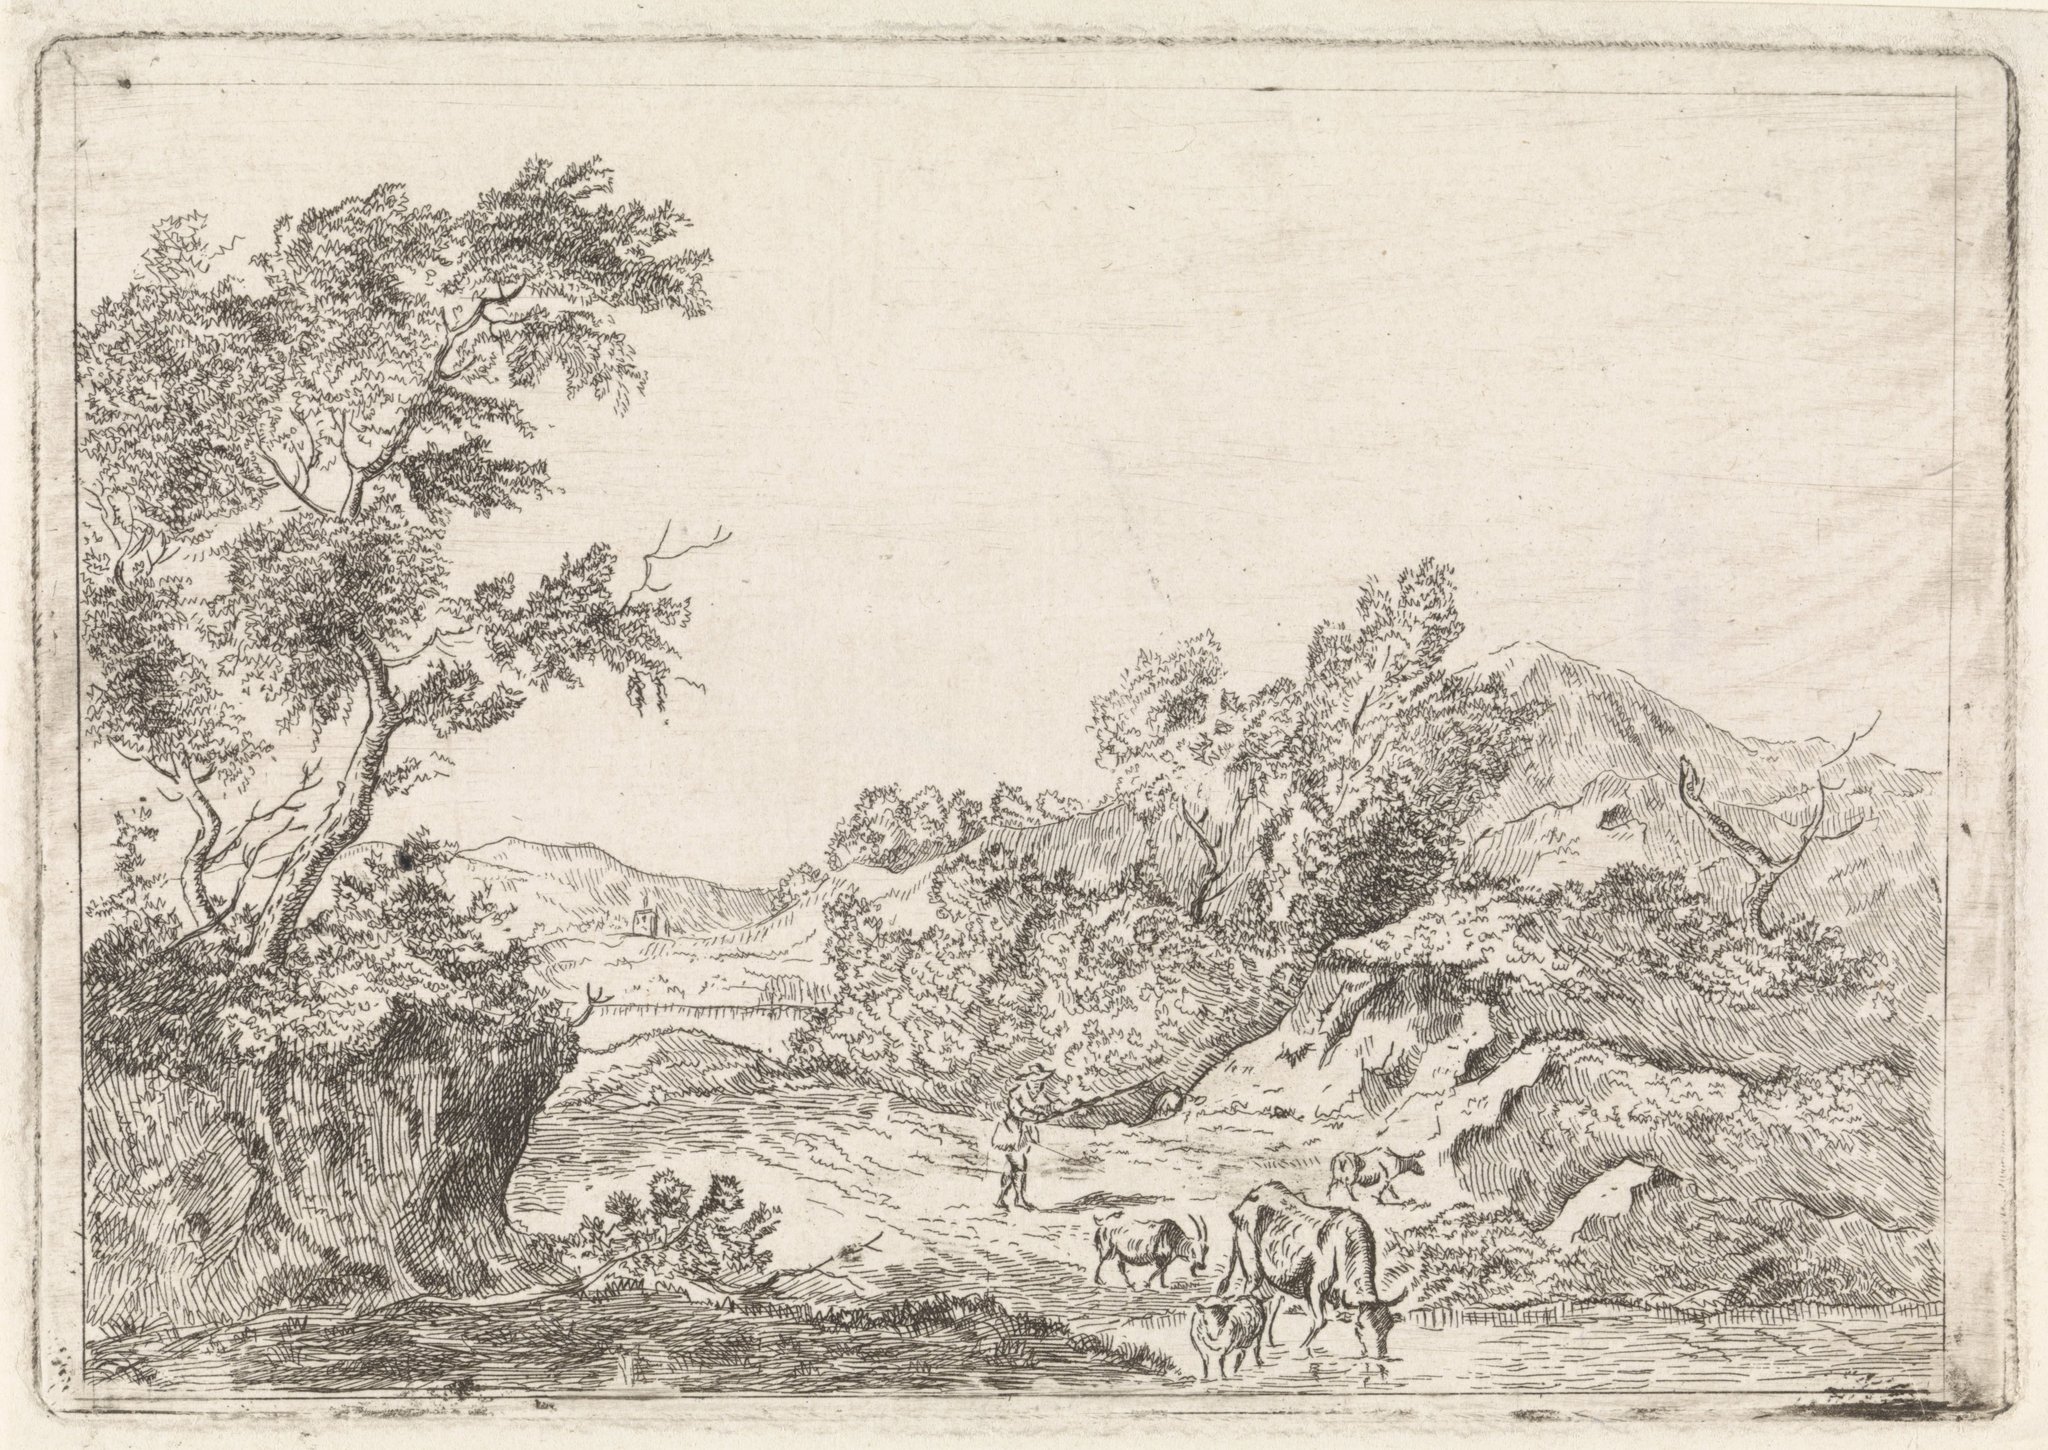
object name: print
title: Bergachtig landschap met vee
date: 1761-1823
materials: paper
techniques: etching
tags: cow, landscapes (+ landscape with figures, staffage)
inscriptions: collector's mark: Lugt 2228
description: Bergachtig landschap met herder, met herderstaf, en zijn vee. Een koe drinkt uit de rivier.